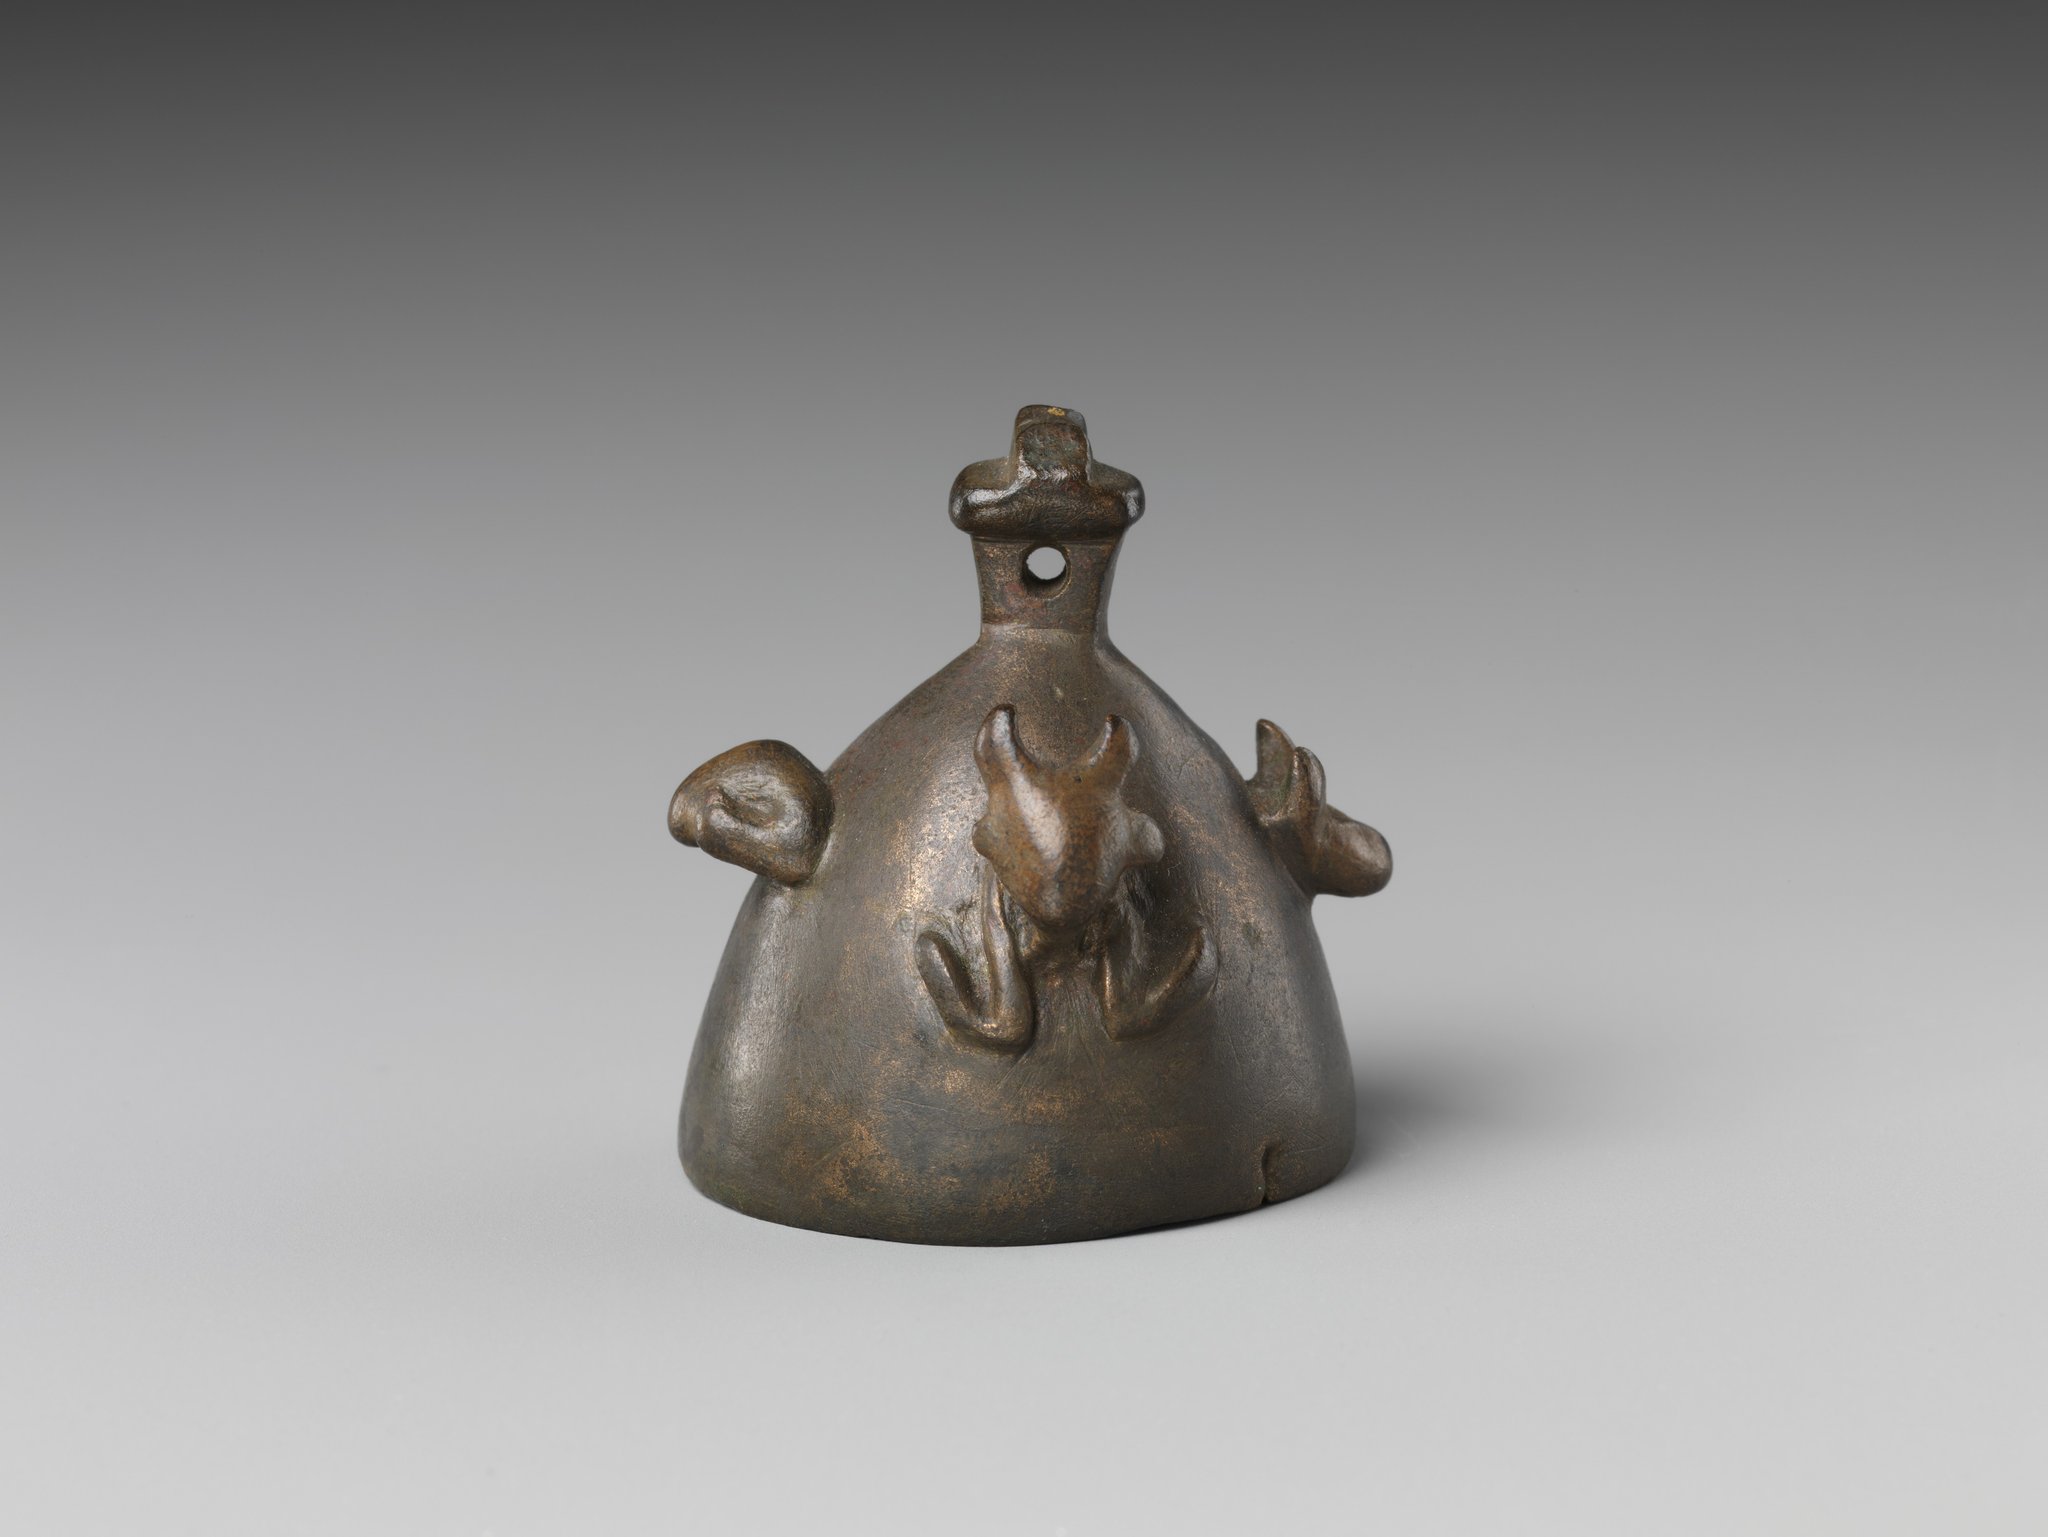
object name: music, bell, ram, jackal, bovine, uraeus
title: Bell with heads of a ram, a jackal, and a bovine wearing a yoke ending in uraei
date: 332-330 BCE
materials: bronze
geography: egypt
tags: rams,snakes,bells,jackals